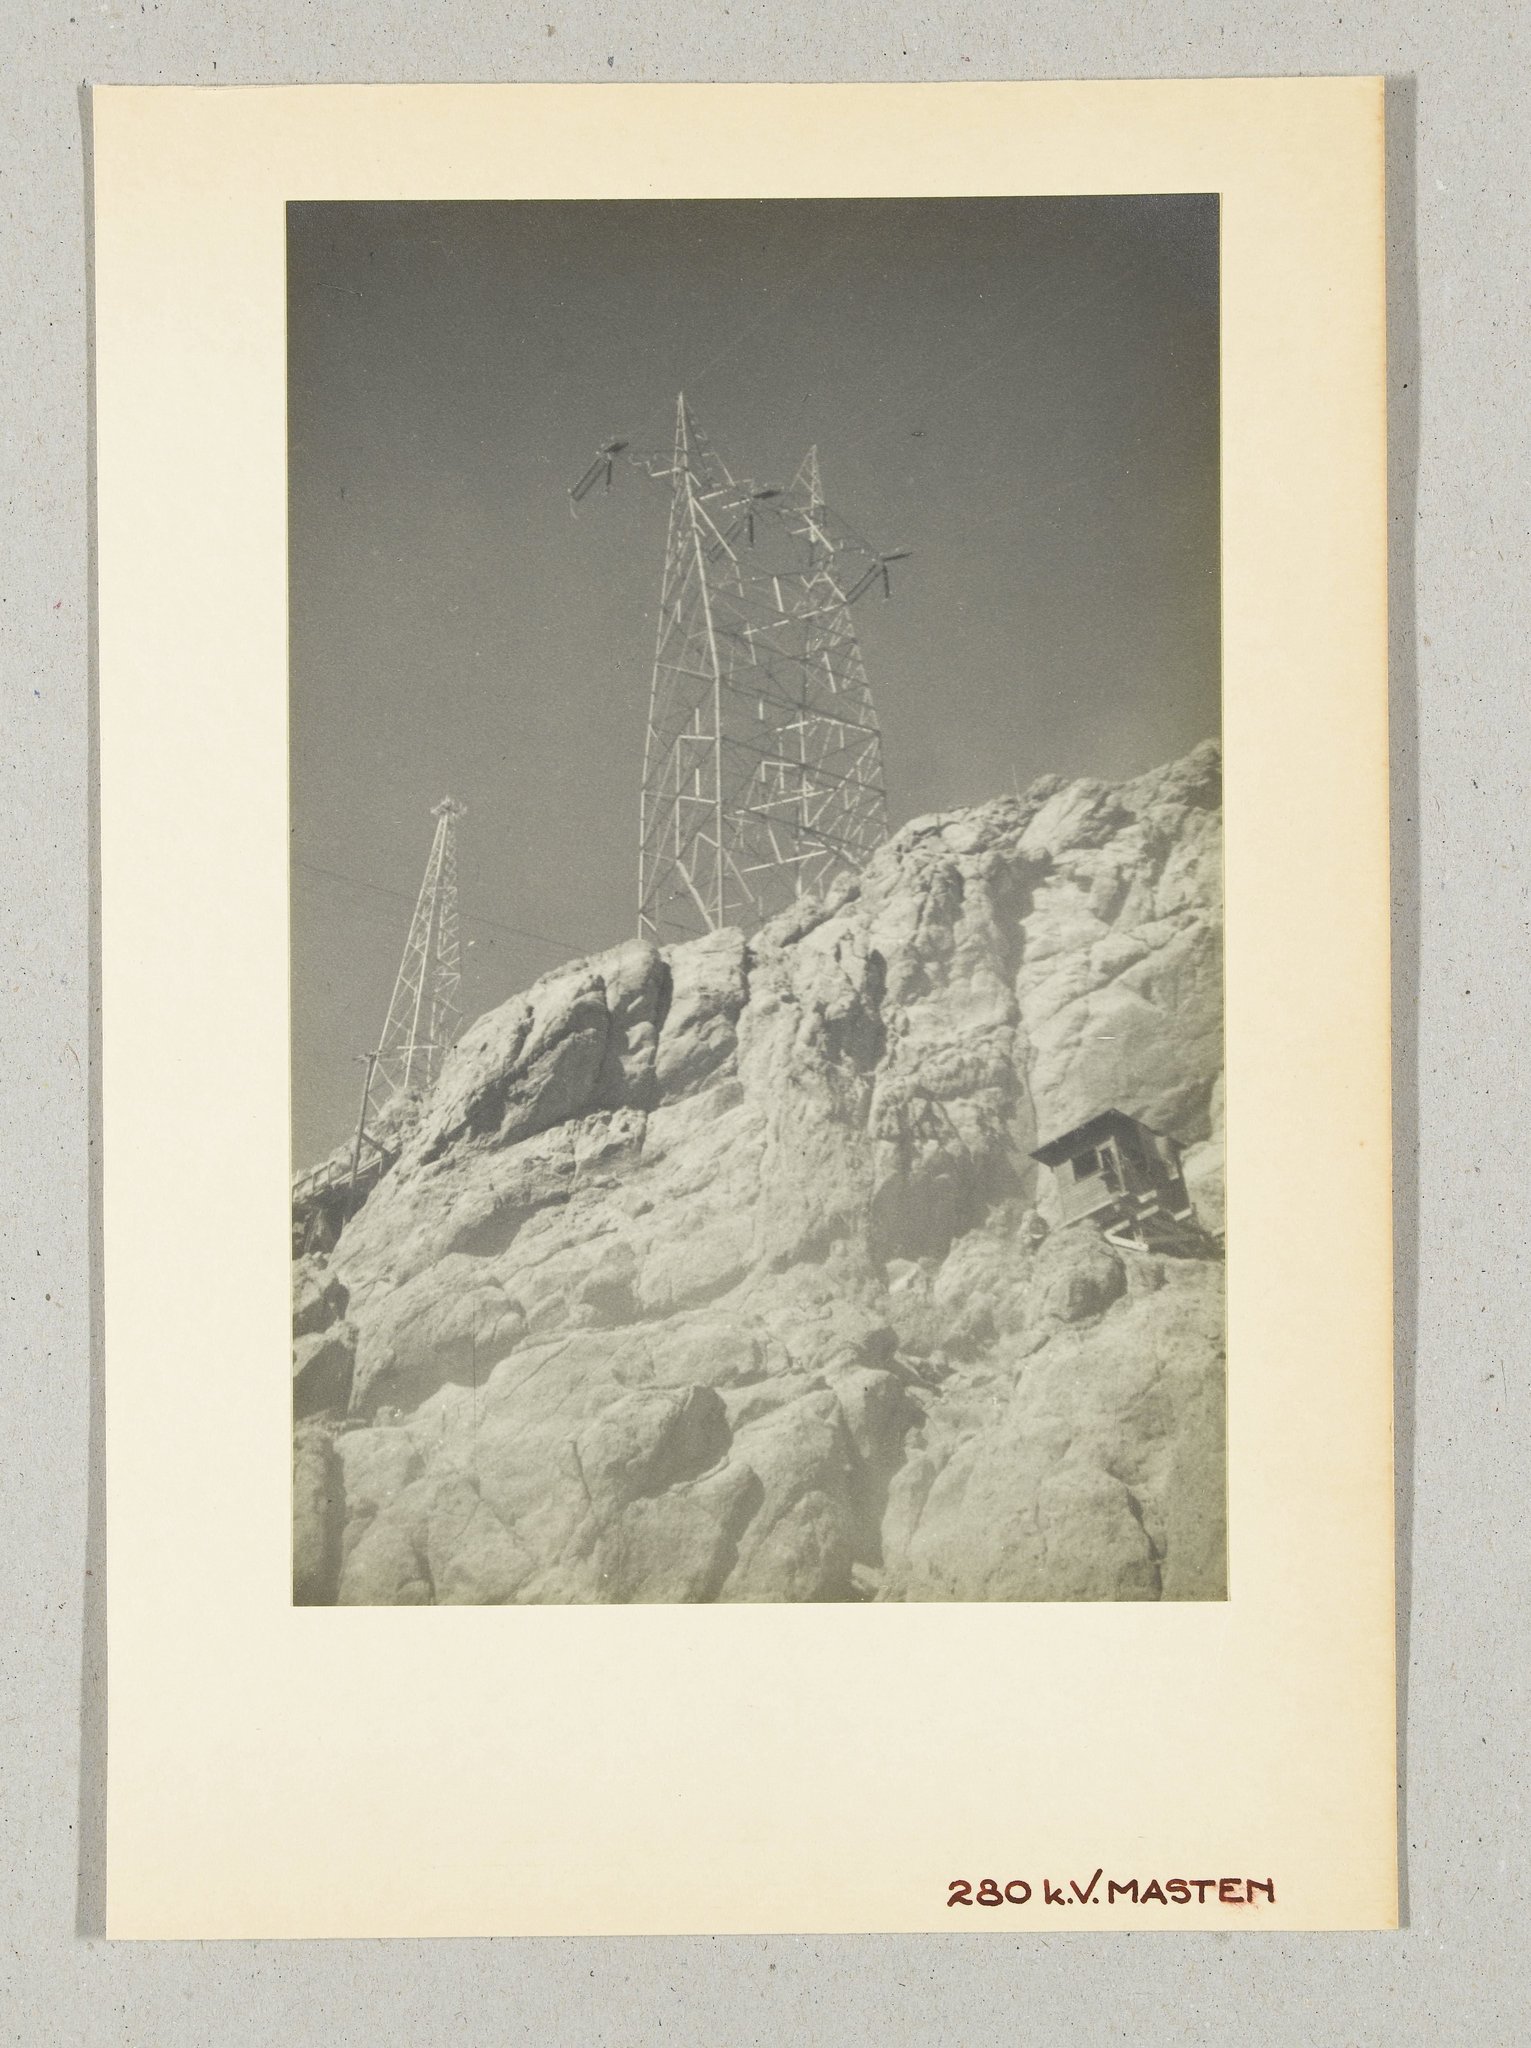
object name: photograph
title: Electriciteitsmasten op onbekende locatie in de Verenigde Staten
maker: wouter cool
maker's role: engineer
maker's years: 1877-1947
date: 1936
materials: cardboard, paper, photographic support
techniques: gelatin silver print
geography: united states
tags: pylons, power lines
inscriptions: title: ‘280 k.V. MASTEN’